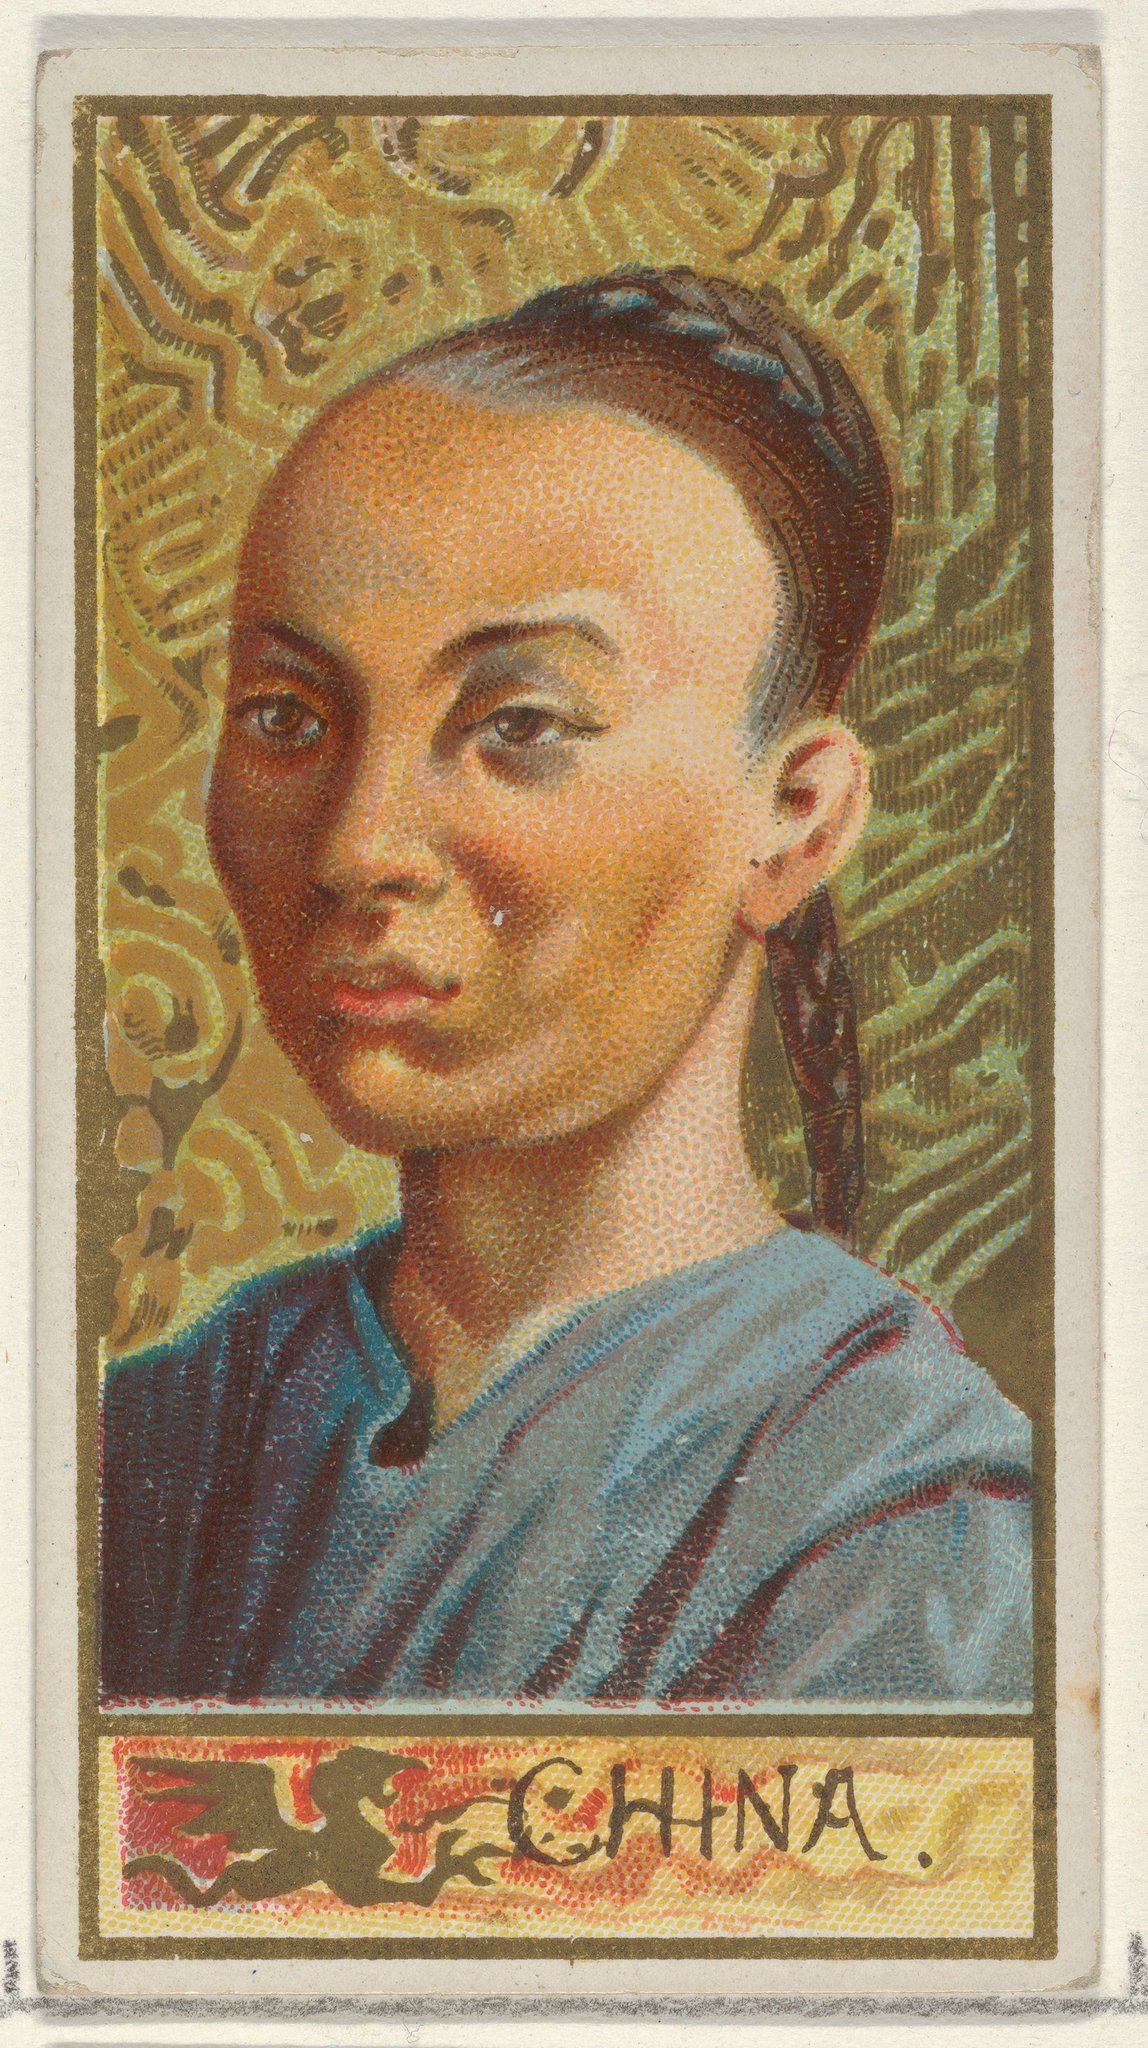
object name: print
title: China, from the Types of All Nations series (N24) for Allen & Ginter Cigarettes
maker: allen & ginter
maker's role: publisher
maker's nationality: american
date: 1889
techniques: color lithograph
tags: women